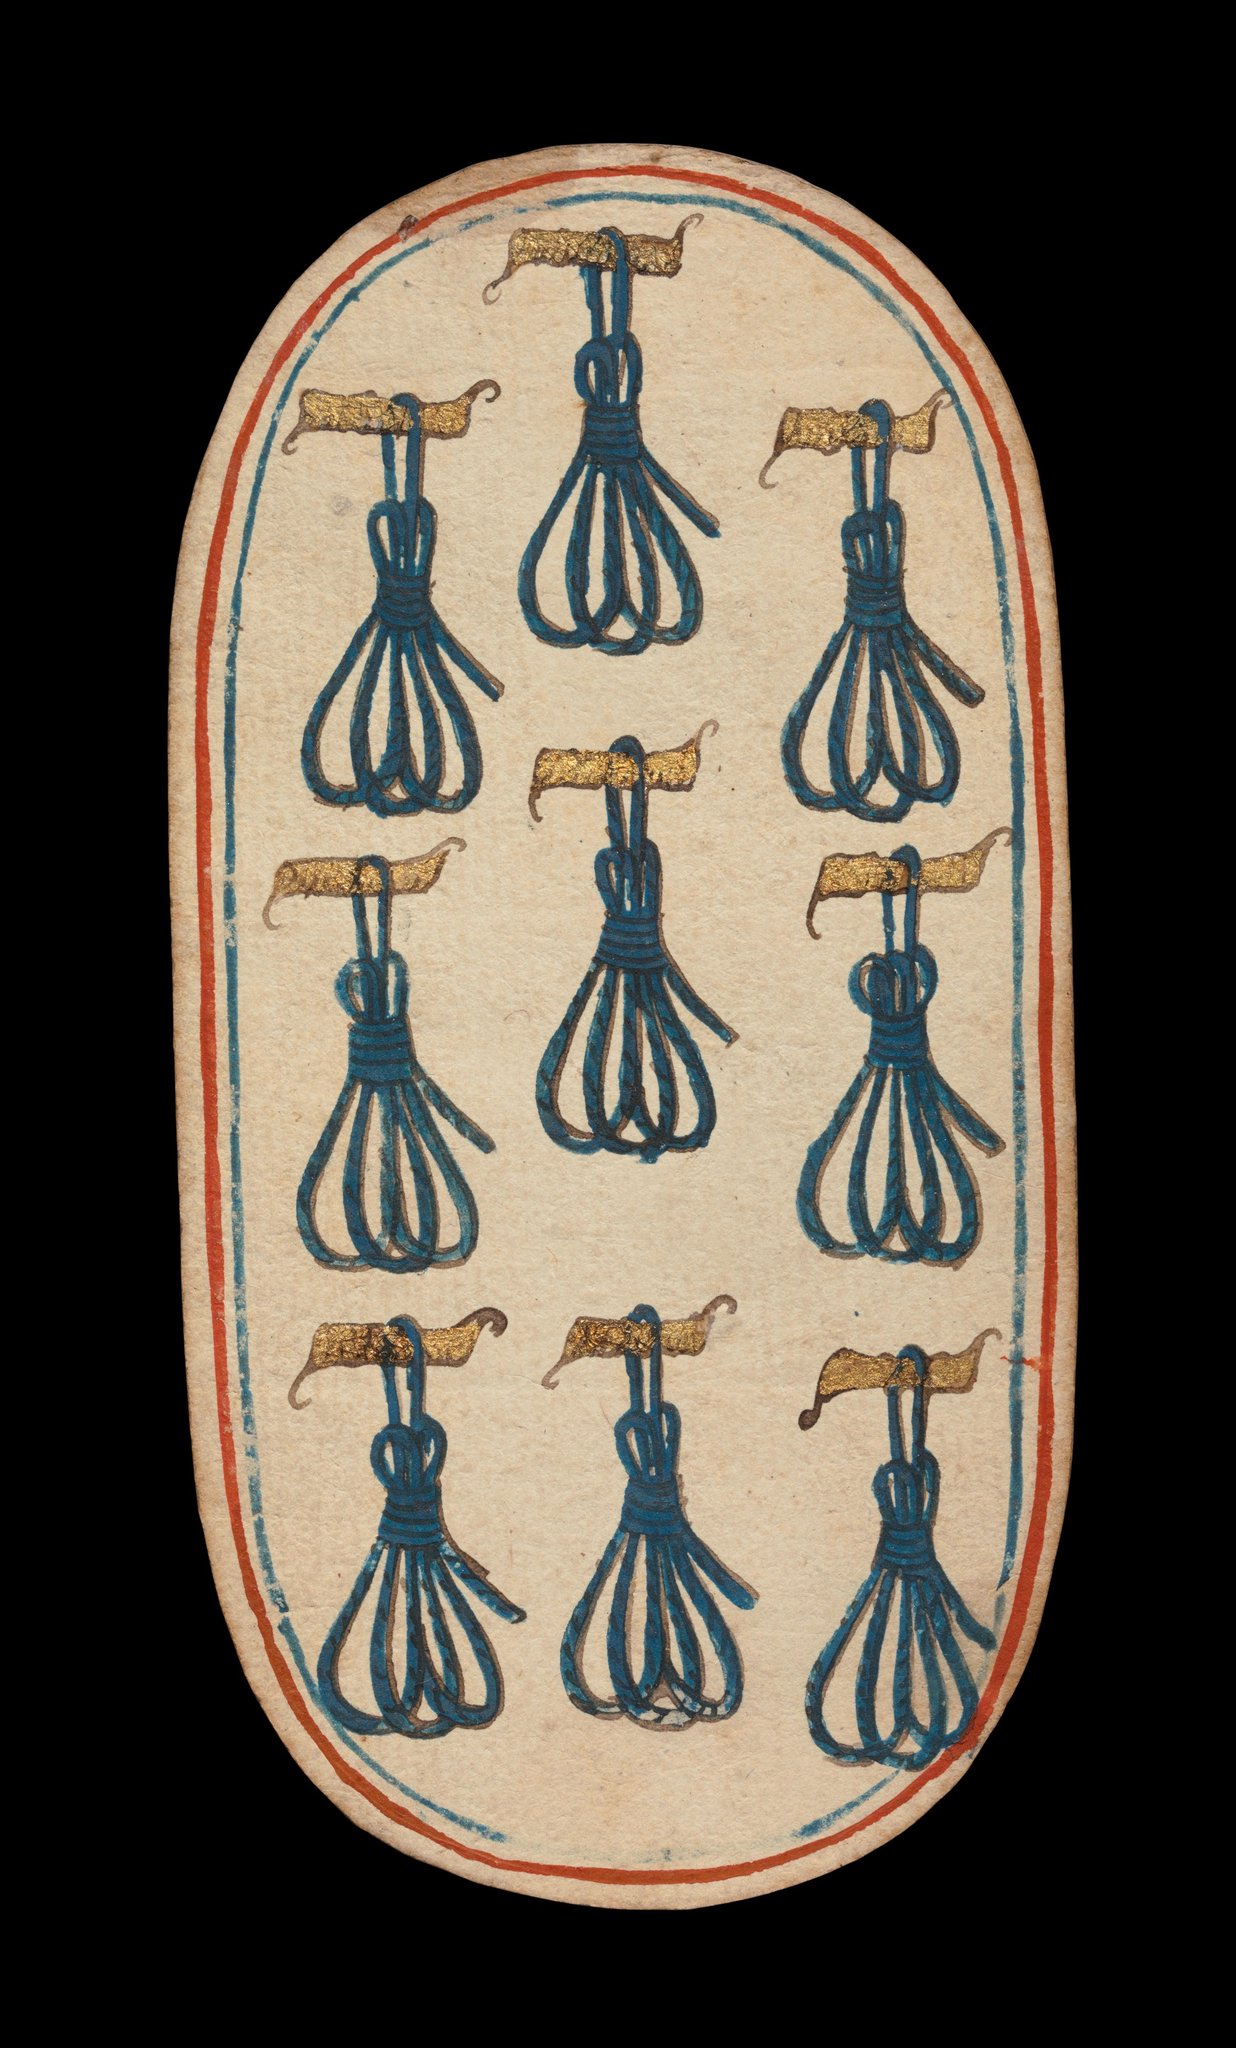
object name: playing card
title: 9 of Tethers, from The Cloisters Playing Cards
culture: south netherlandish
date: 1475-1480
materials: glaze, gold, ink, paint, paper, silver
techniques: pen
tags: playing cards,games